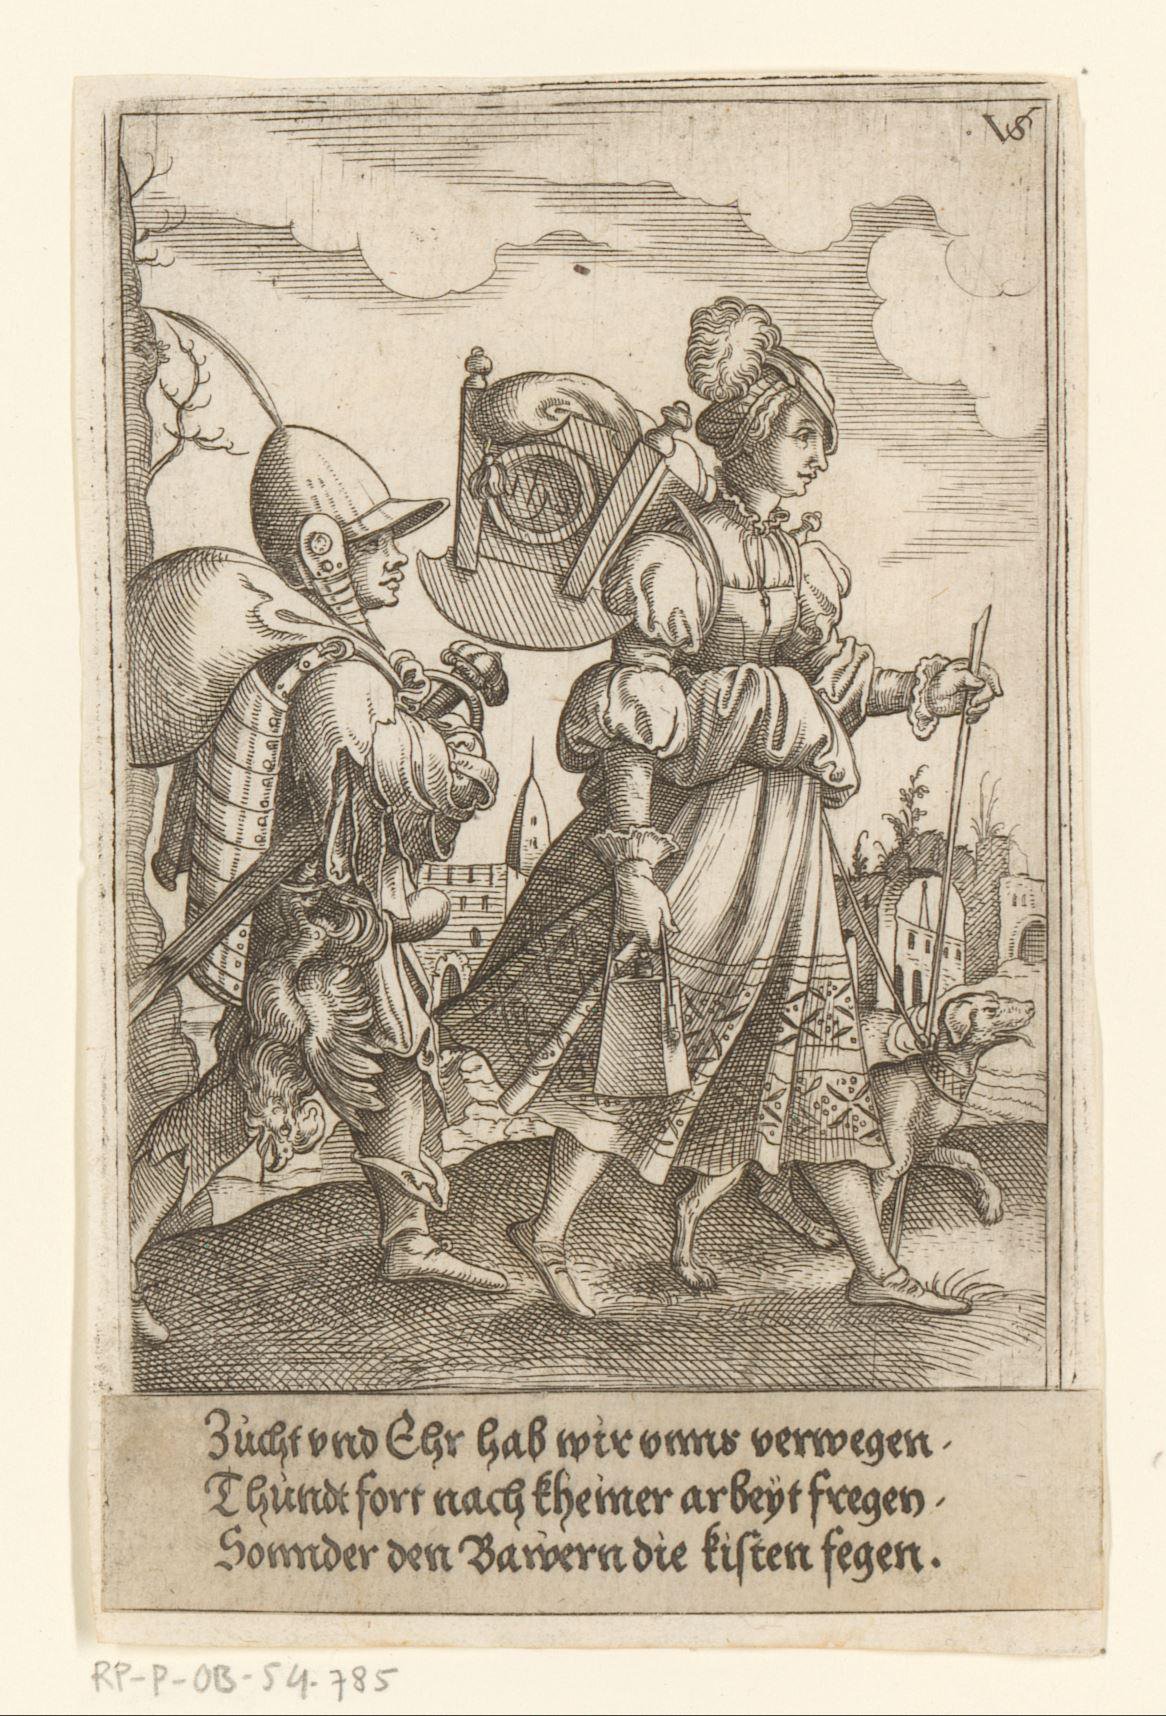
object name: print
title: Militaire figuren staand in landschappen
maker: virgilius solis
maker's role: draughtsman, print maker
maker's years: 1514-1562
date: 1524-1562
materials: paper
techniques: engraving, etching, intaglio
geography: nuremberg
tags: ranks in the army, carrying something in basket, bag, rucksack, etc., fowl (cock, hen, chicken, etc.), the soldier; the soldier's life, female sutler, canteen-woman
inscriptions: number: ‘146’, collector's mark: Lugt 2228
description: Maakt deel uit van een serie van elf prenten met voorstellingen van militaire figuren. Een drieregelige Duitse tekst afkomstig van een onbekende andere prent is als onderschrift onder de voorstelling gemonteerd.